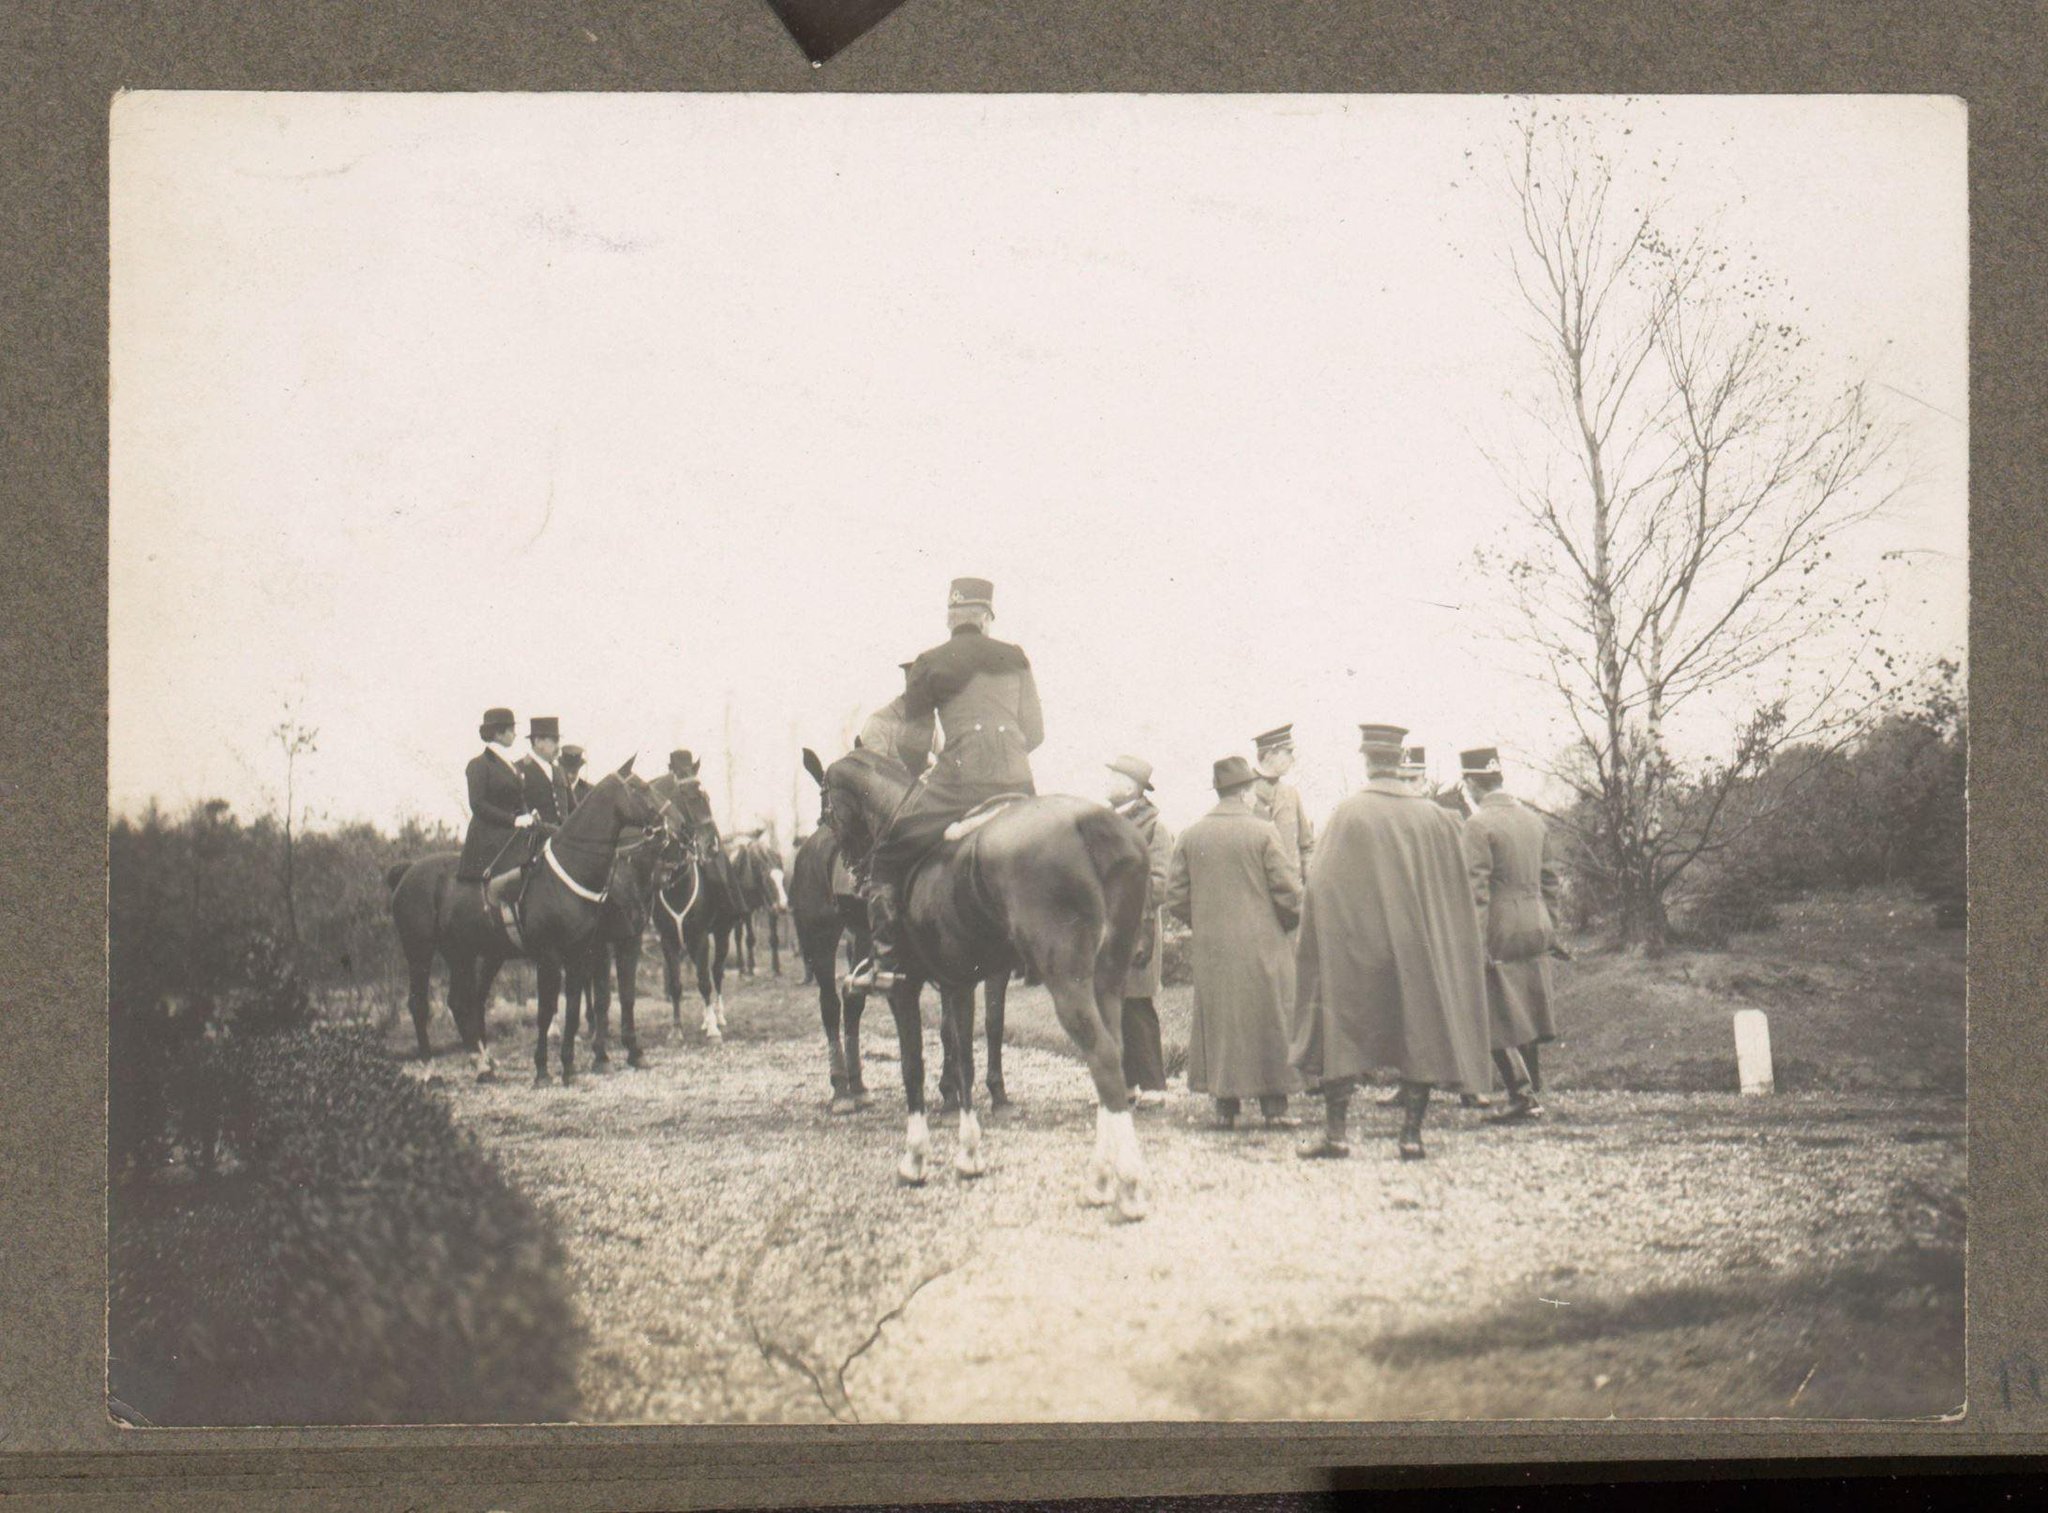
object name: album leaf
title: Ruitertafereel op Koninklijke Houtvesterij Het Loo: ruiters met een meute honden op een landweg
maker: Anonymous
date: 1900-1925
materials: photographic support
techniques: gelatin silver print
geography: het loo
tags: riding a horse, ass, or mule; rider, horseman, hunting, chase, hunting-ground, forest path or lane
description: Onderdeel van Fotoalbum van de heer Brams, opperhoutvester van koningin Wilhelmina op Koninklijke Houtvesterij Het Loo.